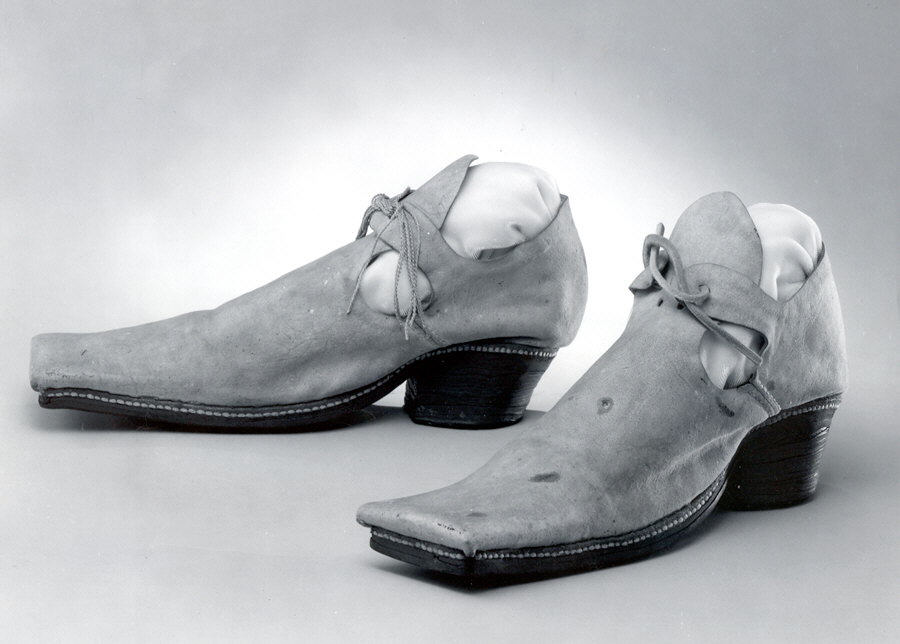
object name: shoe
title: Shoes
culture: european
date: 1660-1675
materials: leather